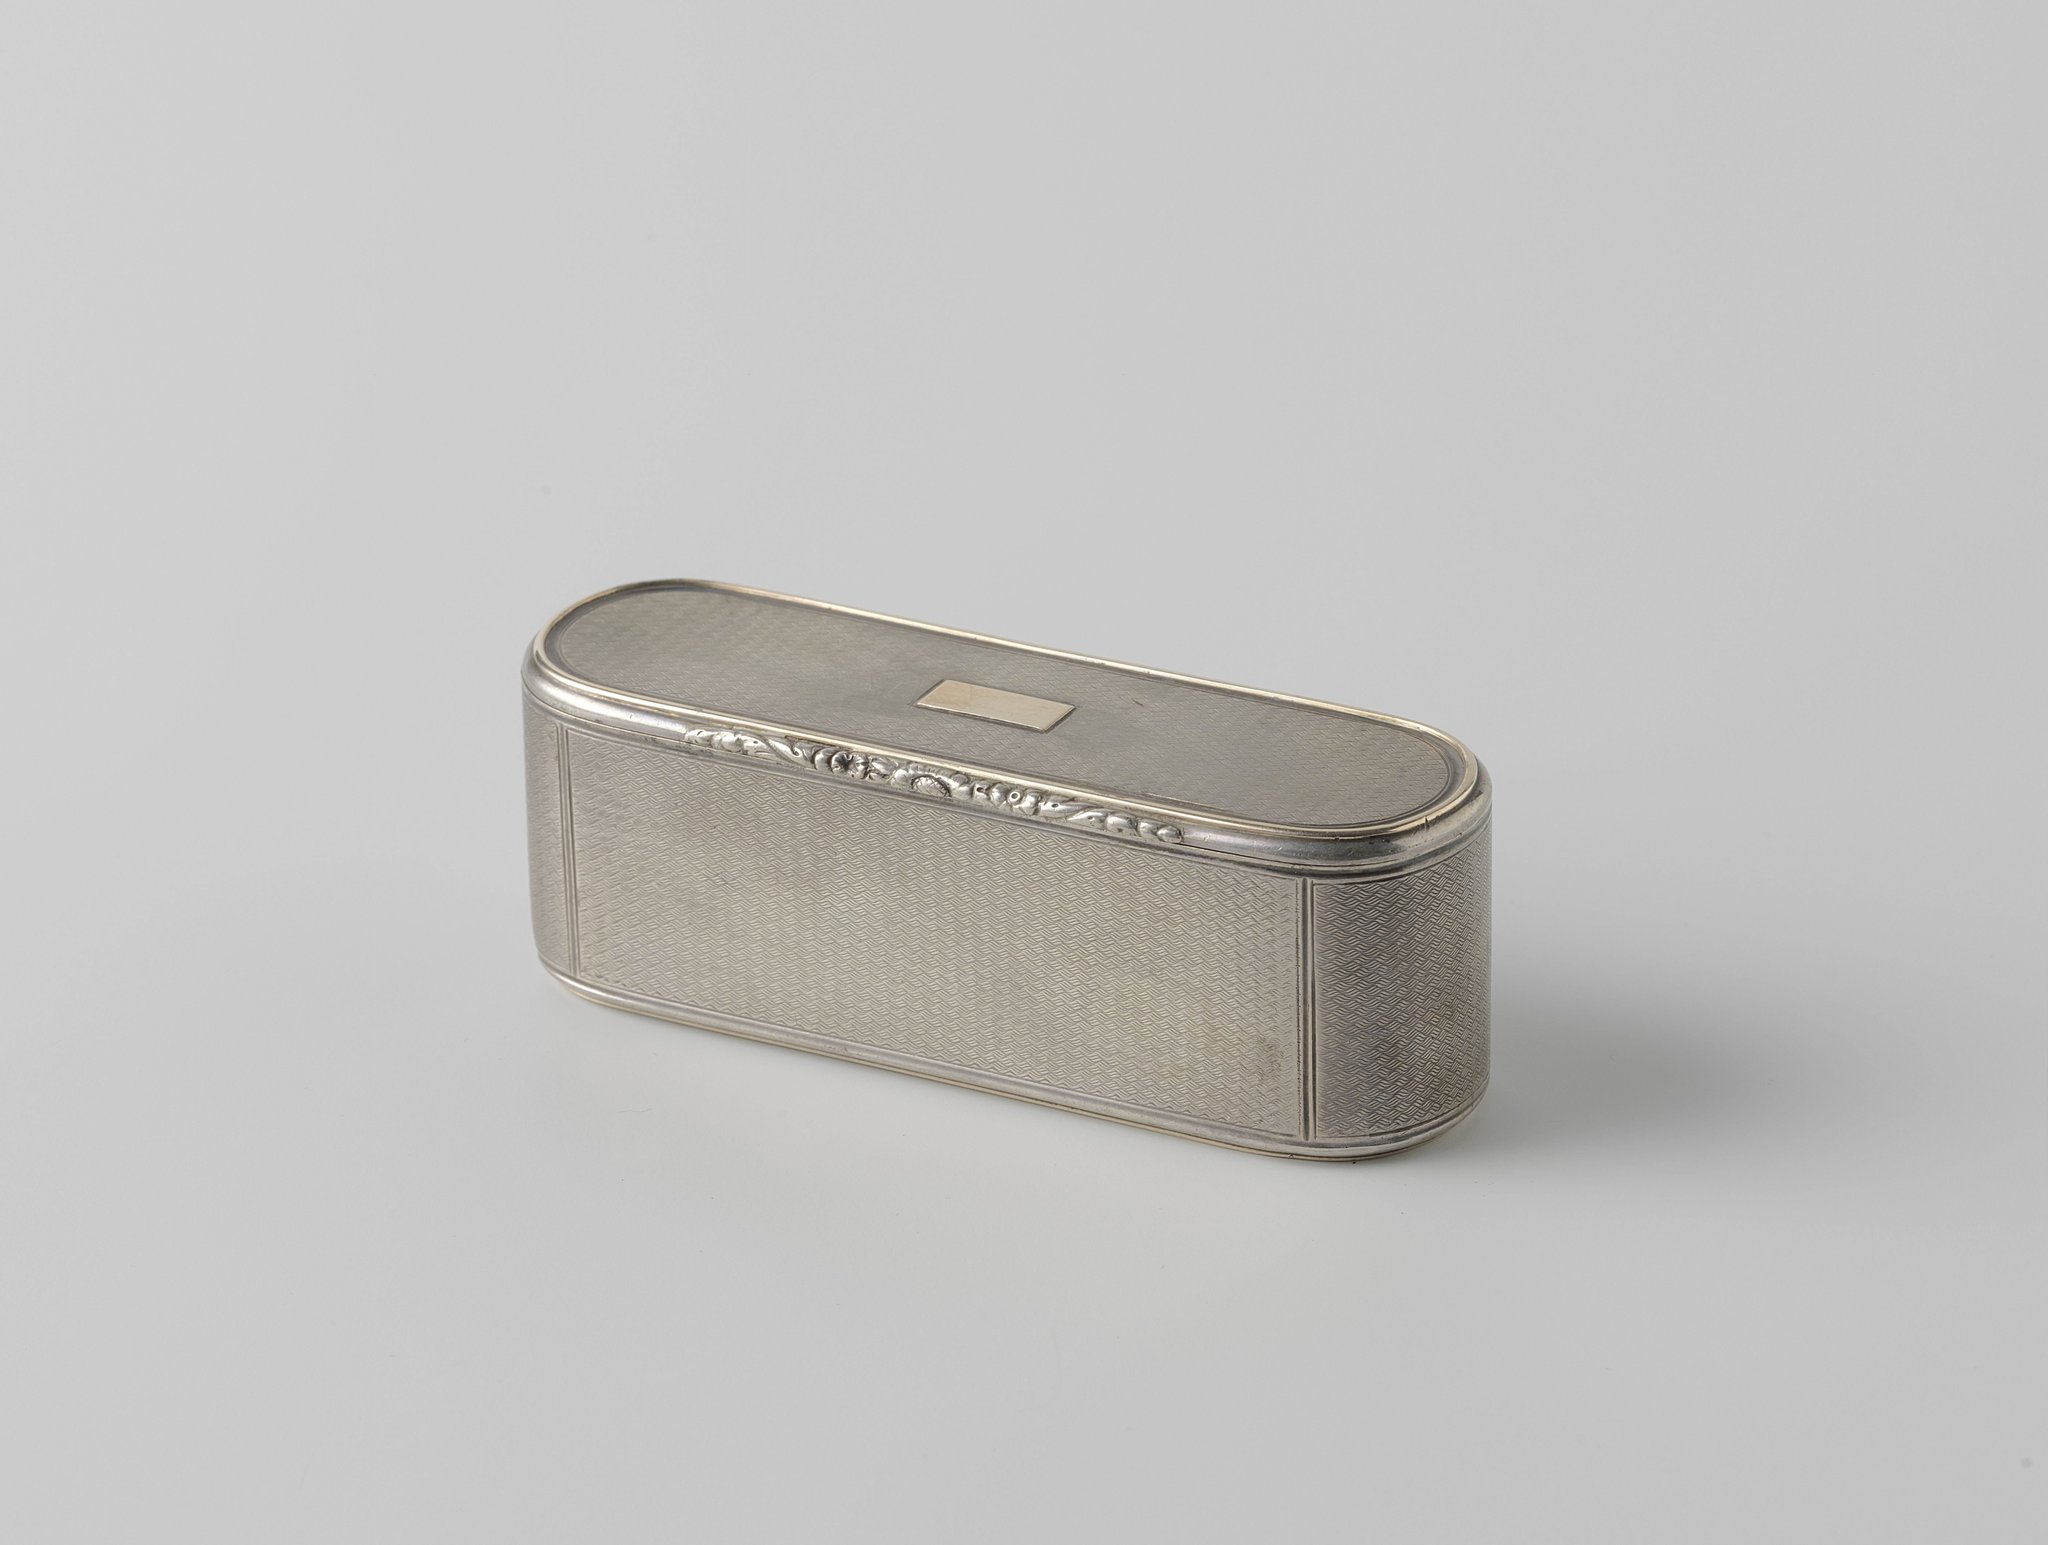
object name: tinder box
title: Tondeldoos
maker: Anonymous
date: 1838-1919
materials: silver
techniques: gilding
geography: france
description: Elipsvormige tondeldoos van zilver. Op het bovenvlak een verguld rechthoekig plaatje. Van binnen verguld. Meesterteken: naar rechts kijkende kop.